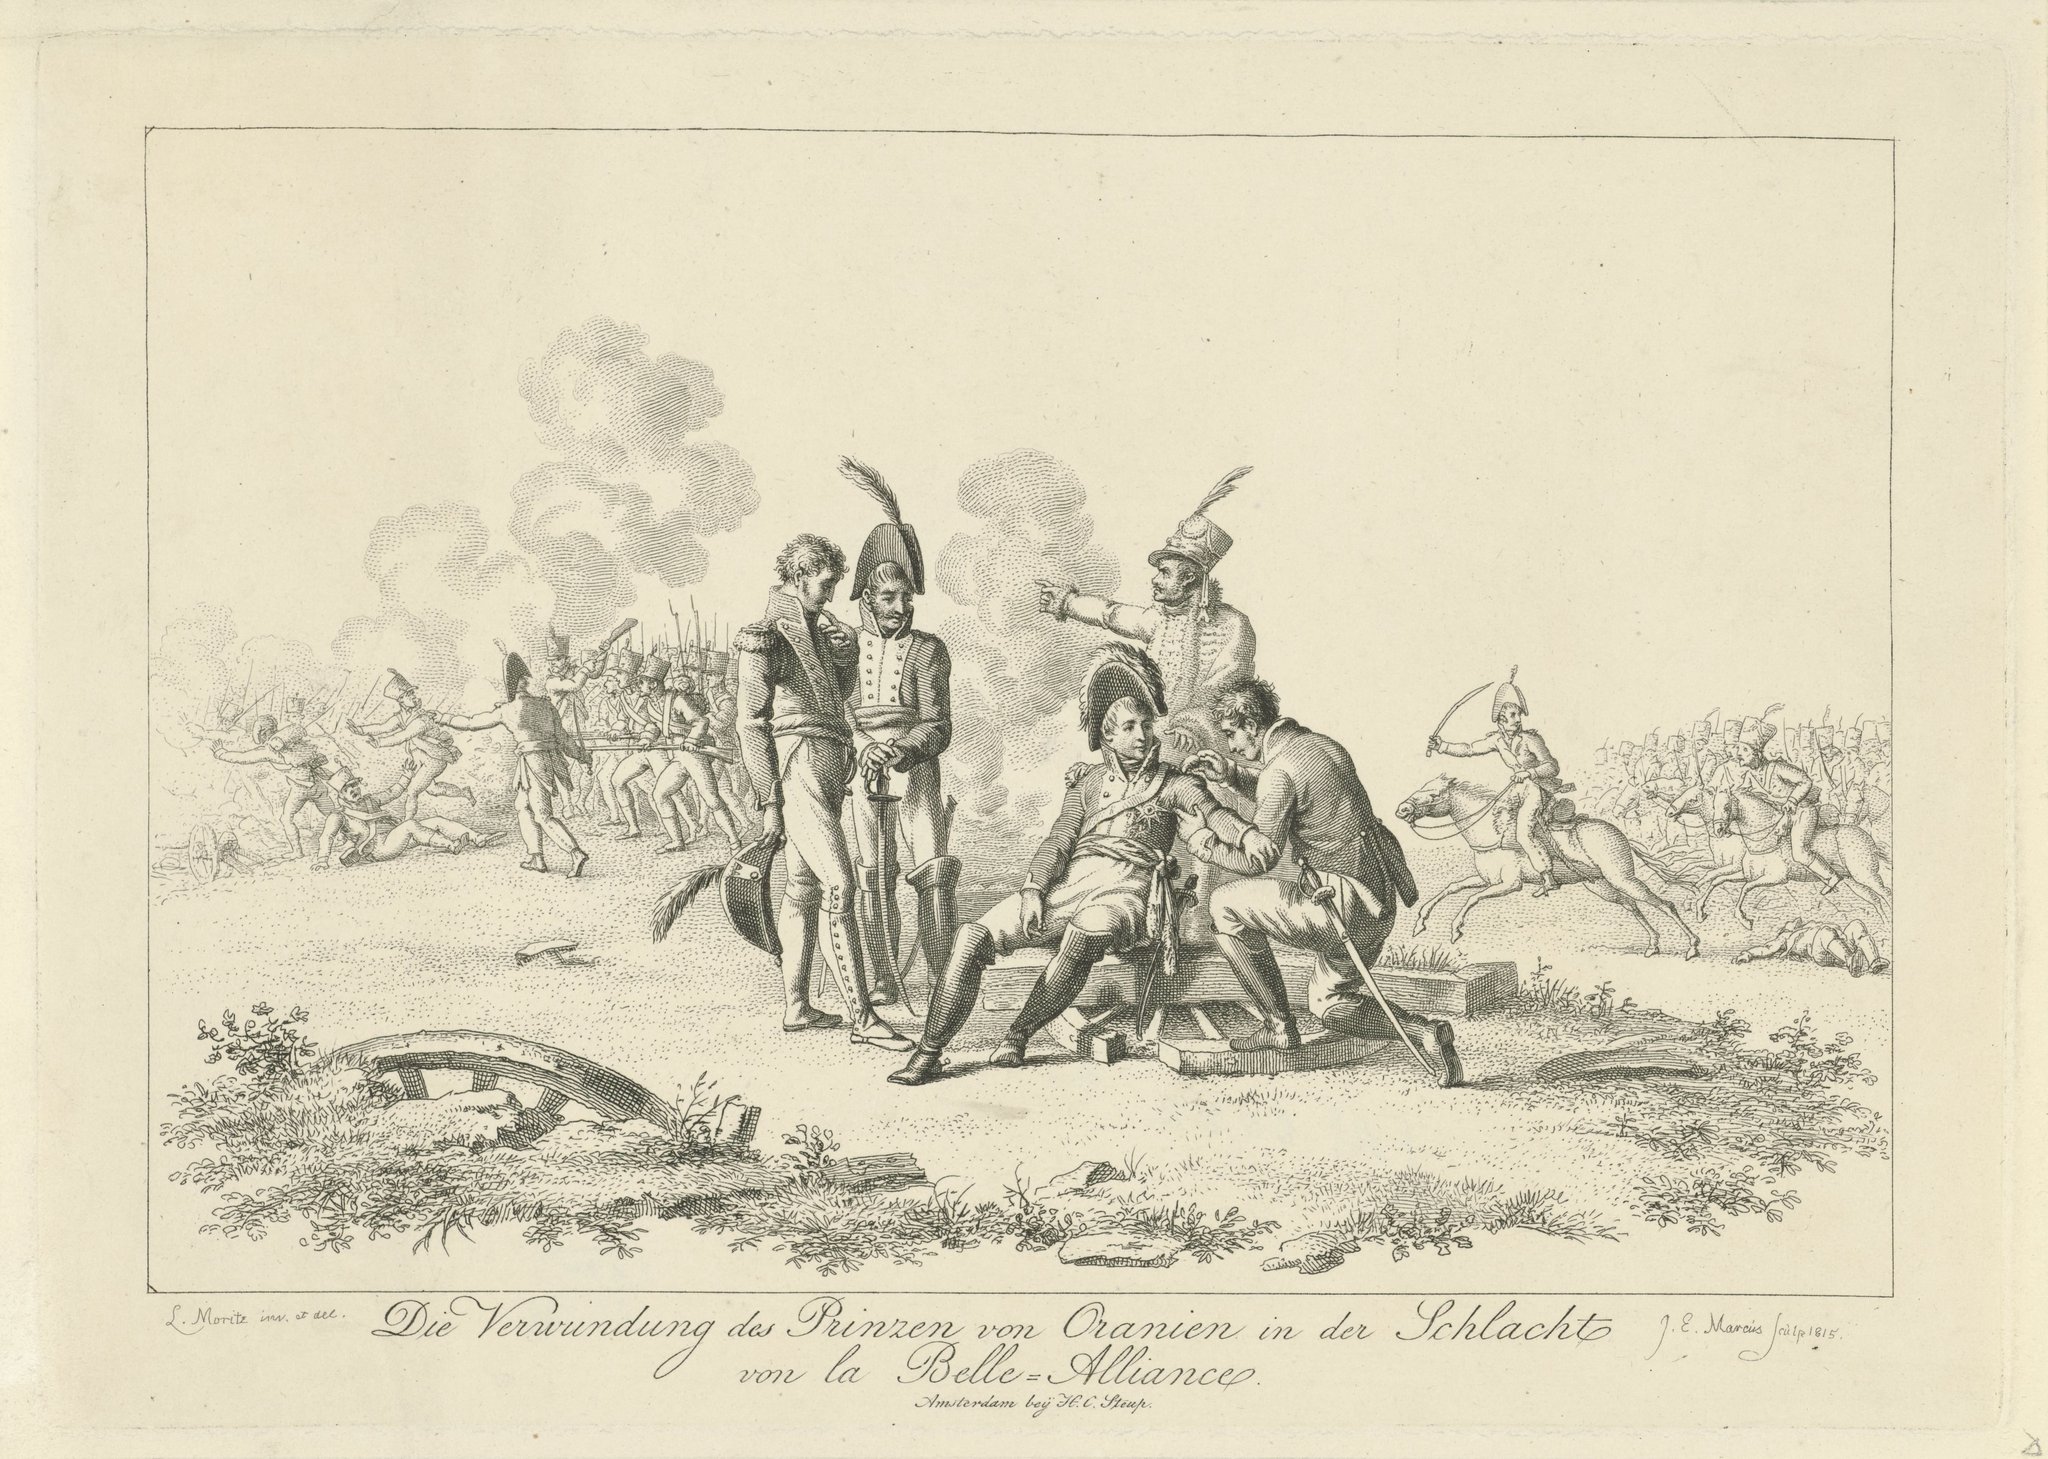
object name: print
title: Die Verwundung des Prinzen von Oranien in der Schlacht von la Belle-Alliance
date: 1815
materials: paper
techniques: etching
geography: amsterdam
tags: the hague, william ii of the netherlands, putting out of action by wounding, battle (+ during the battle)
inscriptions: collector's mark: Lugt 2228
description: De prins van Oranje, de latere Willem II, koning der Nederlanden, heeft een schotwond in zijn arm opgelopen tijdens de Slag bij Waterloo, welke op de achtergrond doorwoedt. Om hem heen staan drie officieren en naast hem is een man neergeknield die zijn wond bekijkt.